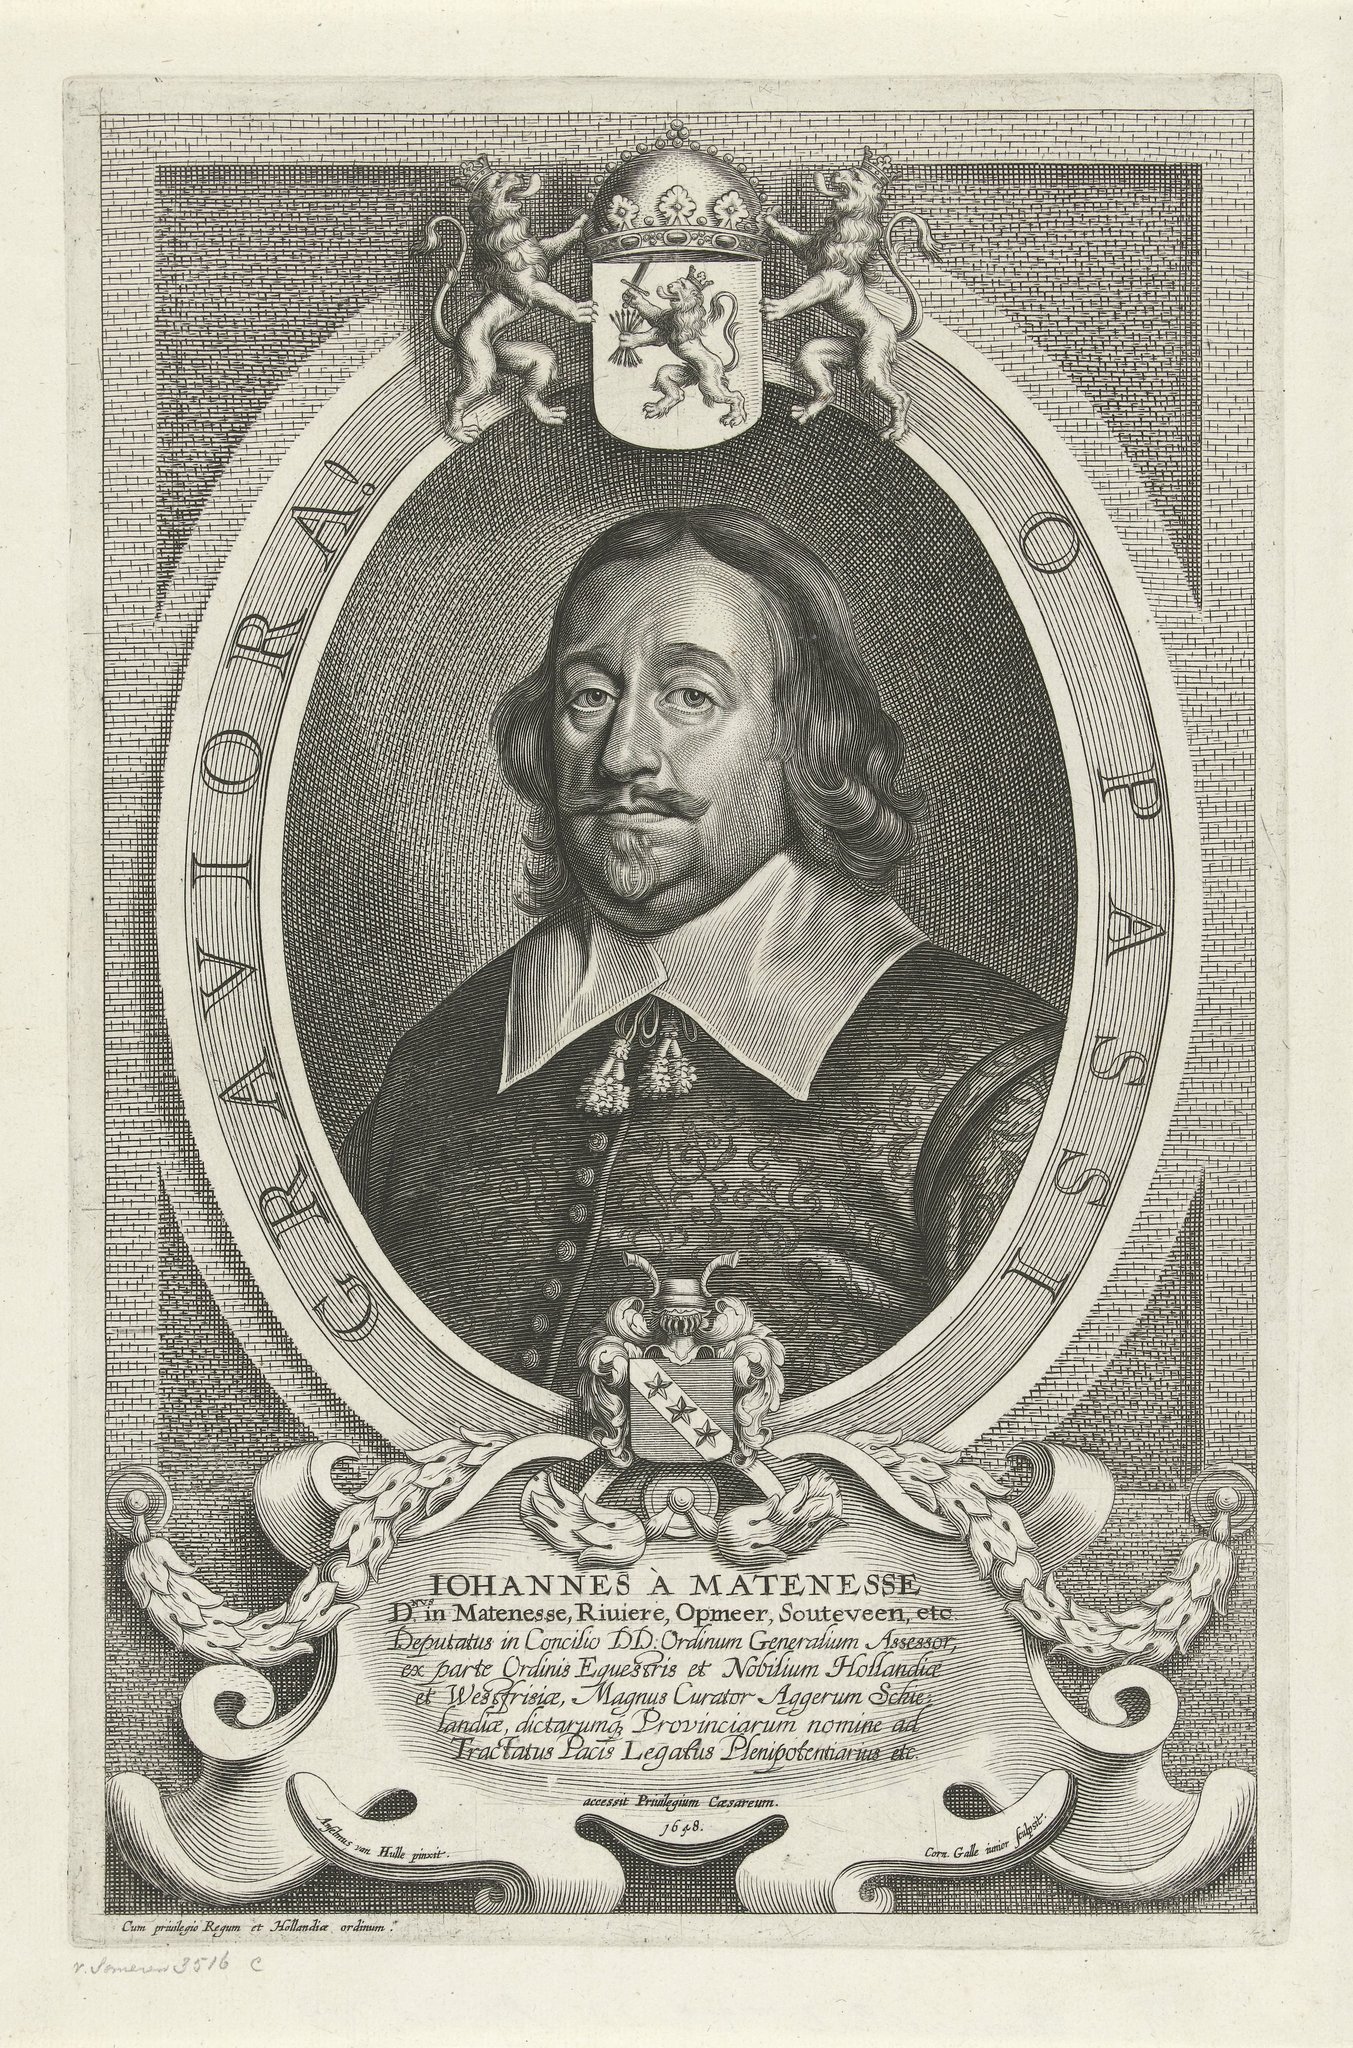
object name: print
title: Celeberrimi ad pacificandum Christiani nominis orbem legati Monasterium et Osnabrugas (...)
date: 1648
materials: paper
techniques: engraving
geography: antwerp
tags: staatsman, diplomaat, johan van mathenesse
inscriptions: collector's mark: Lugt 2228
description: Portret van Johann van Mathenesse, in ovaal met randschrift. Van Mathenesse was afgezant van Holland en Westfriesland tijdens de onderhandelingen voor de Vrede van Münster, boven het portret het wapen van Holland en onder zijn familiewapen.